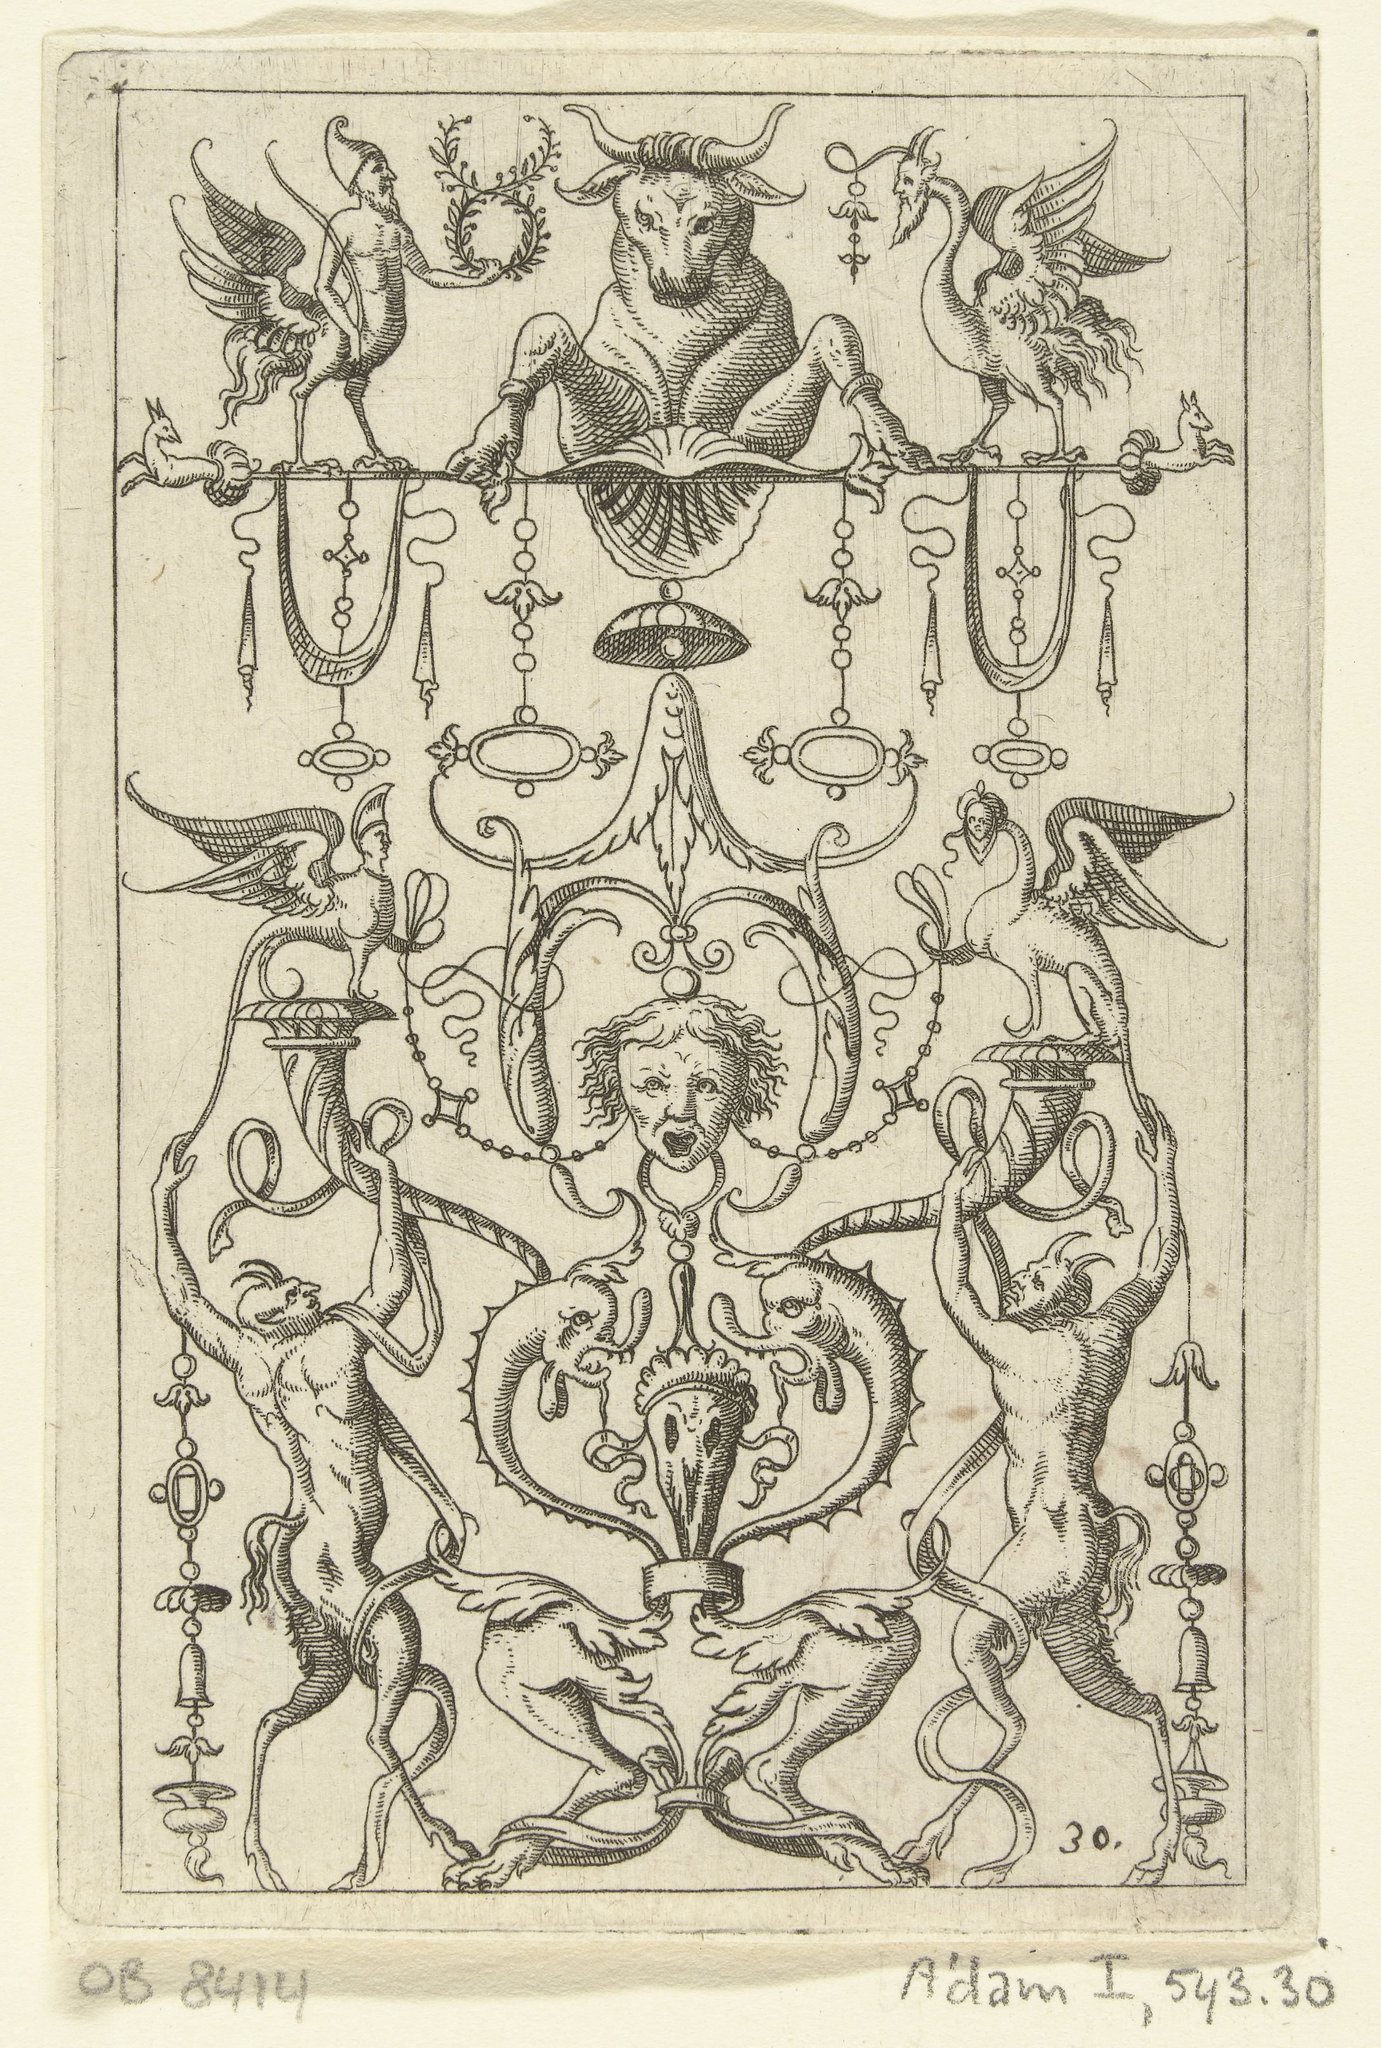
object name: print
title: Iacobus Androuetius Du Cerceau inventor ante annos non paucos conscripsit (...)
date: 1525-1594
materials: paper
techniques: etching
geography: germany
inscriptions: collector's mark: Lugt 240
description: Gelijkzijdige kopie naar prent van Jacques Androuet Ducerceau, ontleend aan een vlakdecoratie van Agostino Veneziano. Blad uit serie met architectuurfantasieën en grotesken met fabelwezens, guirlandes, kandelabers en mascarons.